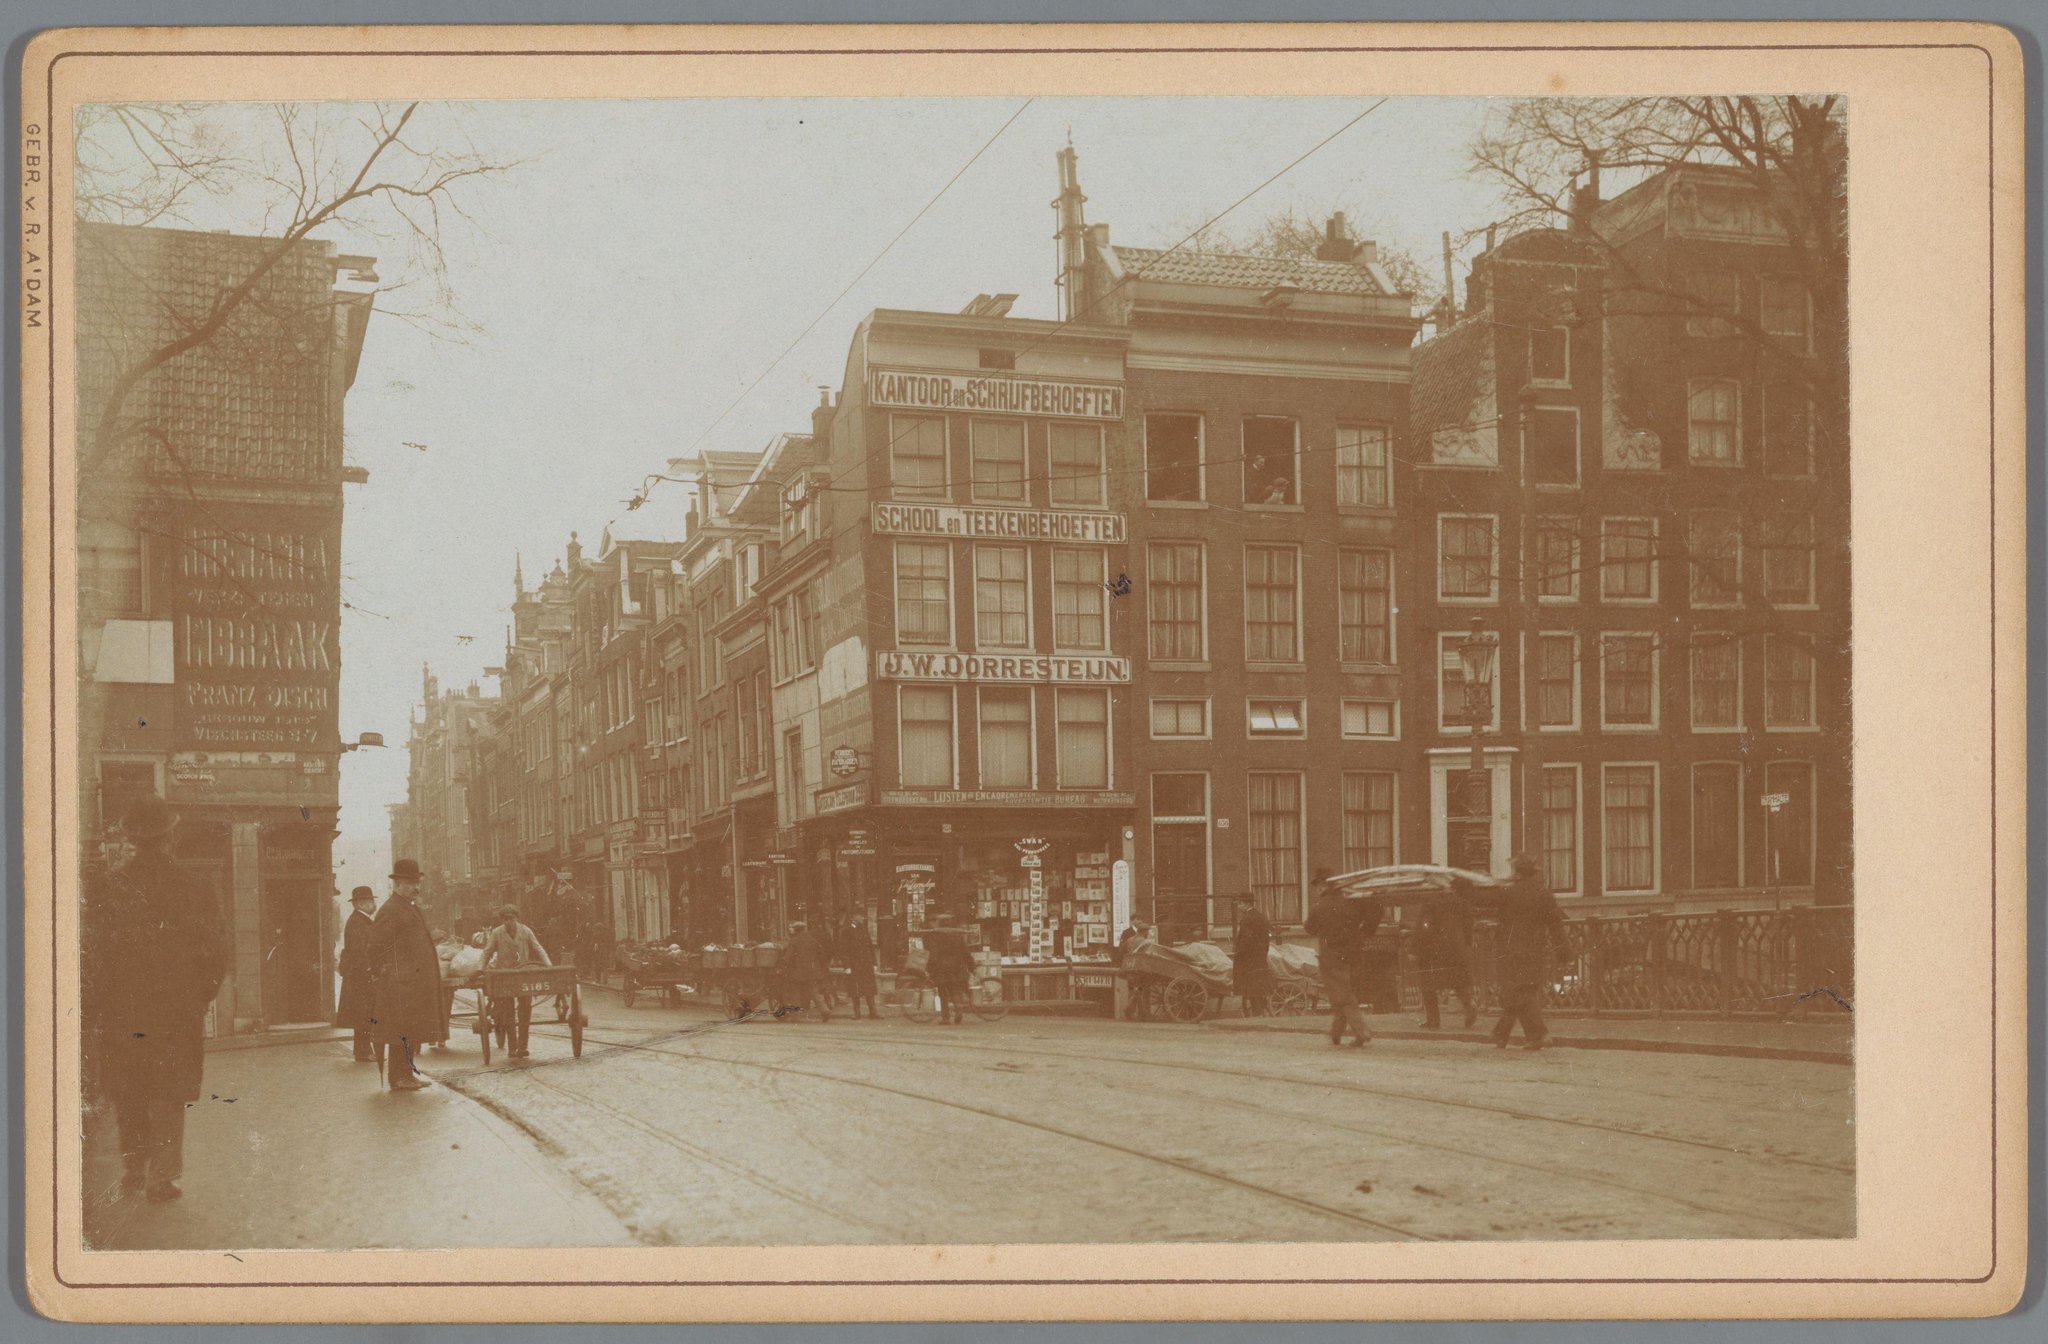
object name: cabinet photograph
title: Gezicht op de Vijzelstraat vanaf de Keizersgracht in Amsterdam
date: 1880-1900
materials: cardboard, photographic support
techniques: collodion silver print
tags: street, shop-window, show-window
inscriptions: inscription: ‘Oude Huizen aan de Keizersgracht en de Vijzelstraat, ziende naar de Prinsengracht. Afgebroken ter Verbreeding van de Vijzelstraat.’, name: ‘Vosmaer’